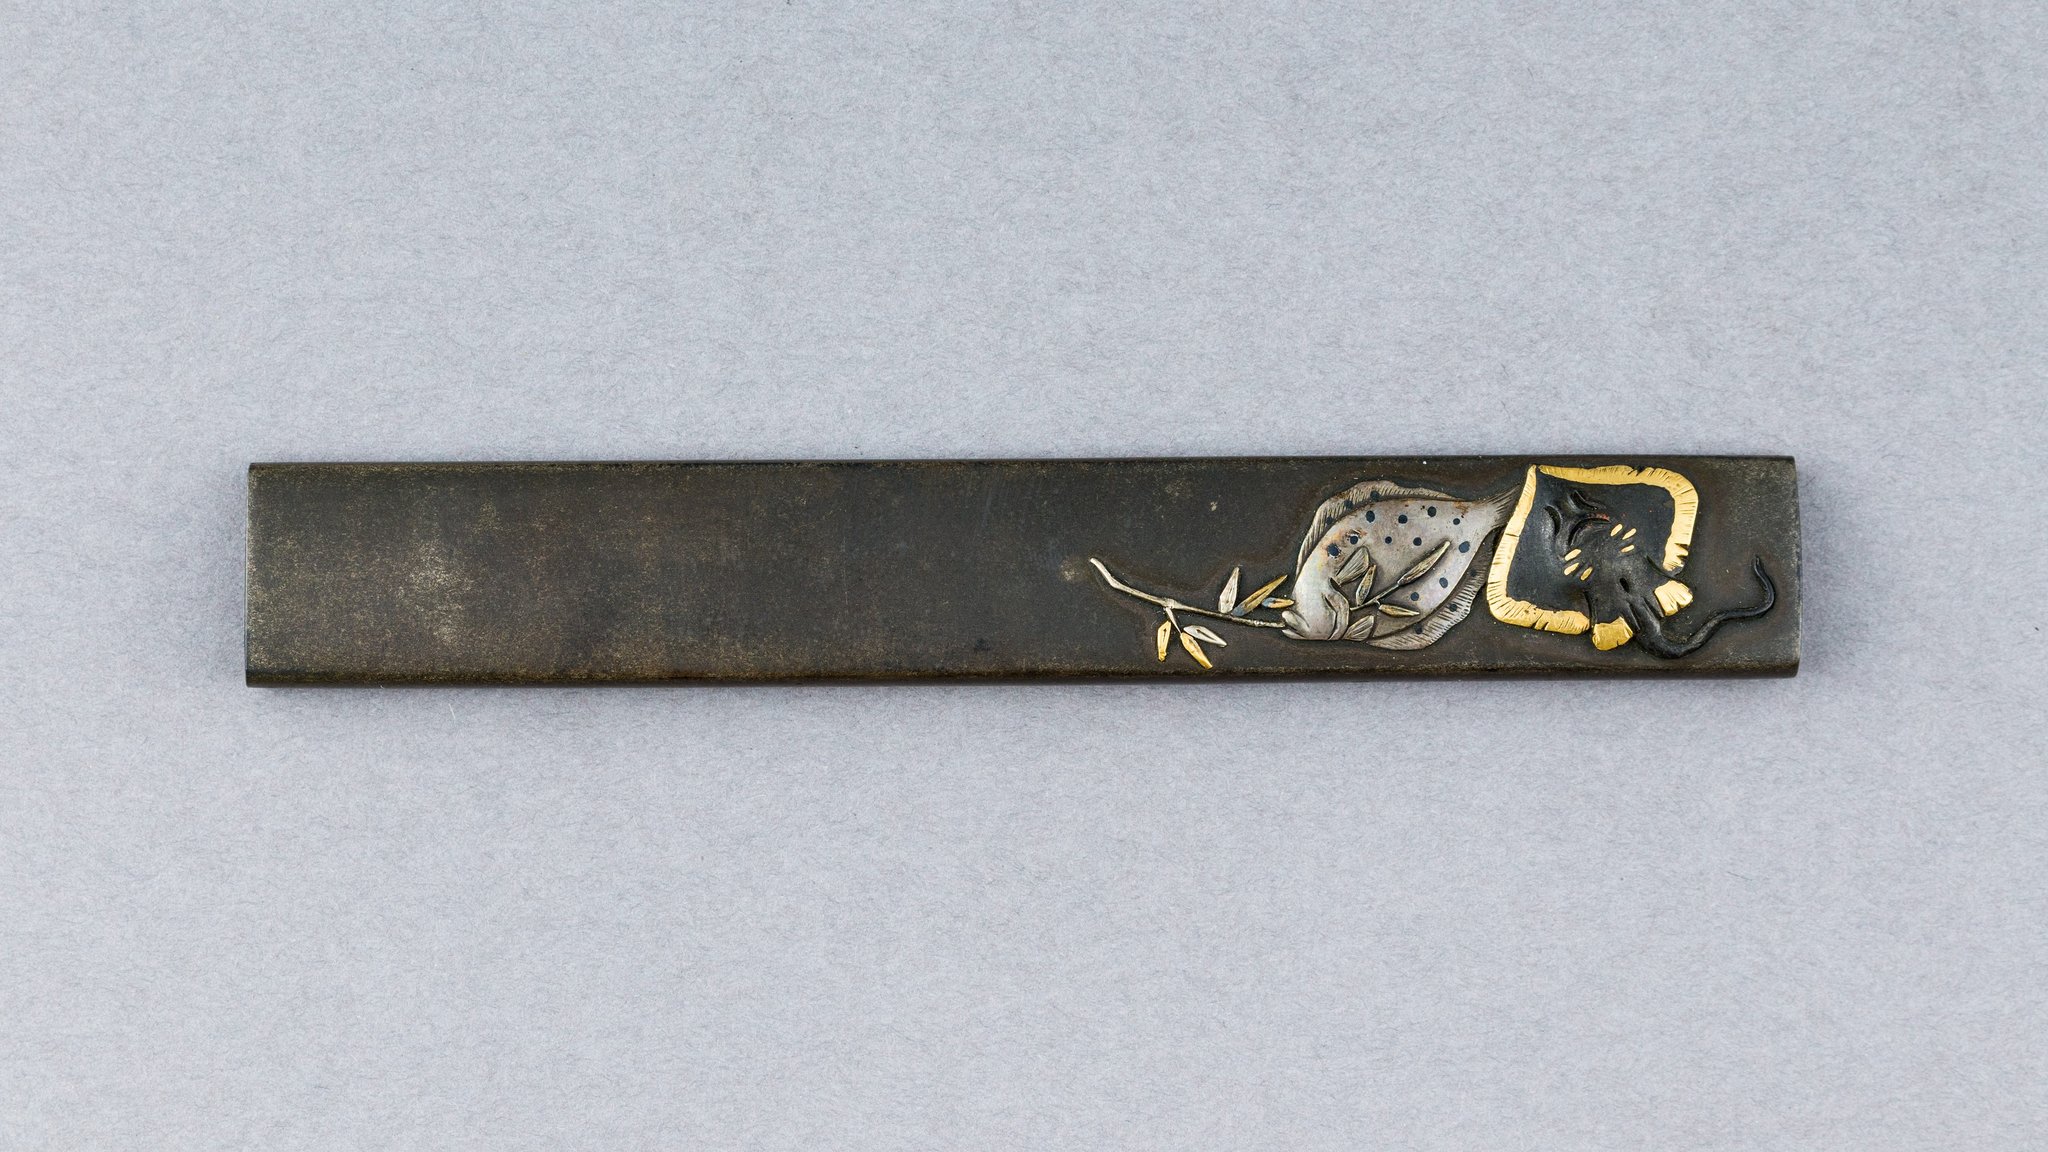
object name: knife handle kozuka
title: Knife Handle (Kozuka)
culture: japanese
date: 1615-1868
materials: silver alloy, gold, silver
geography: japan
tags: fish